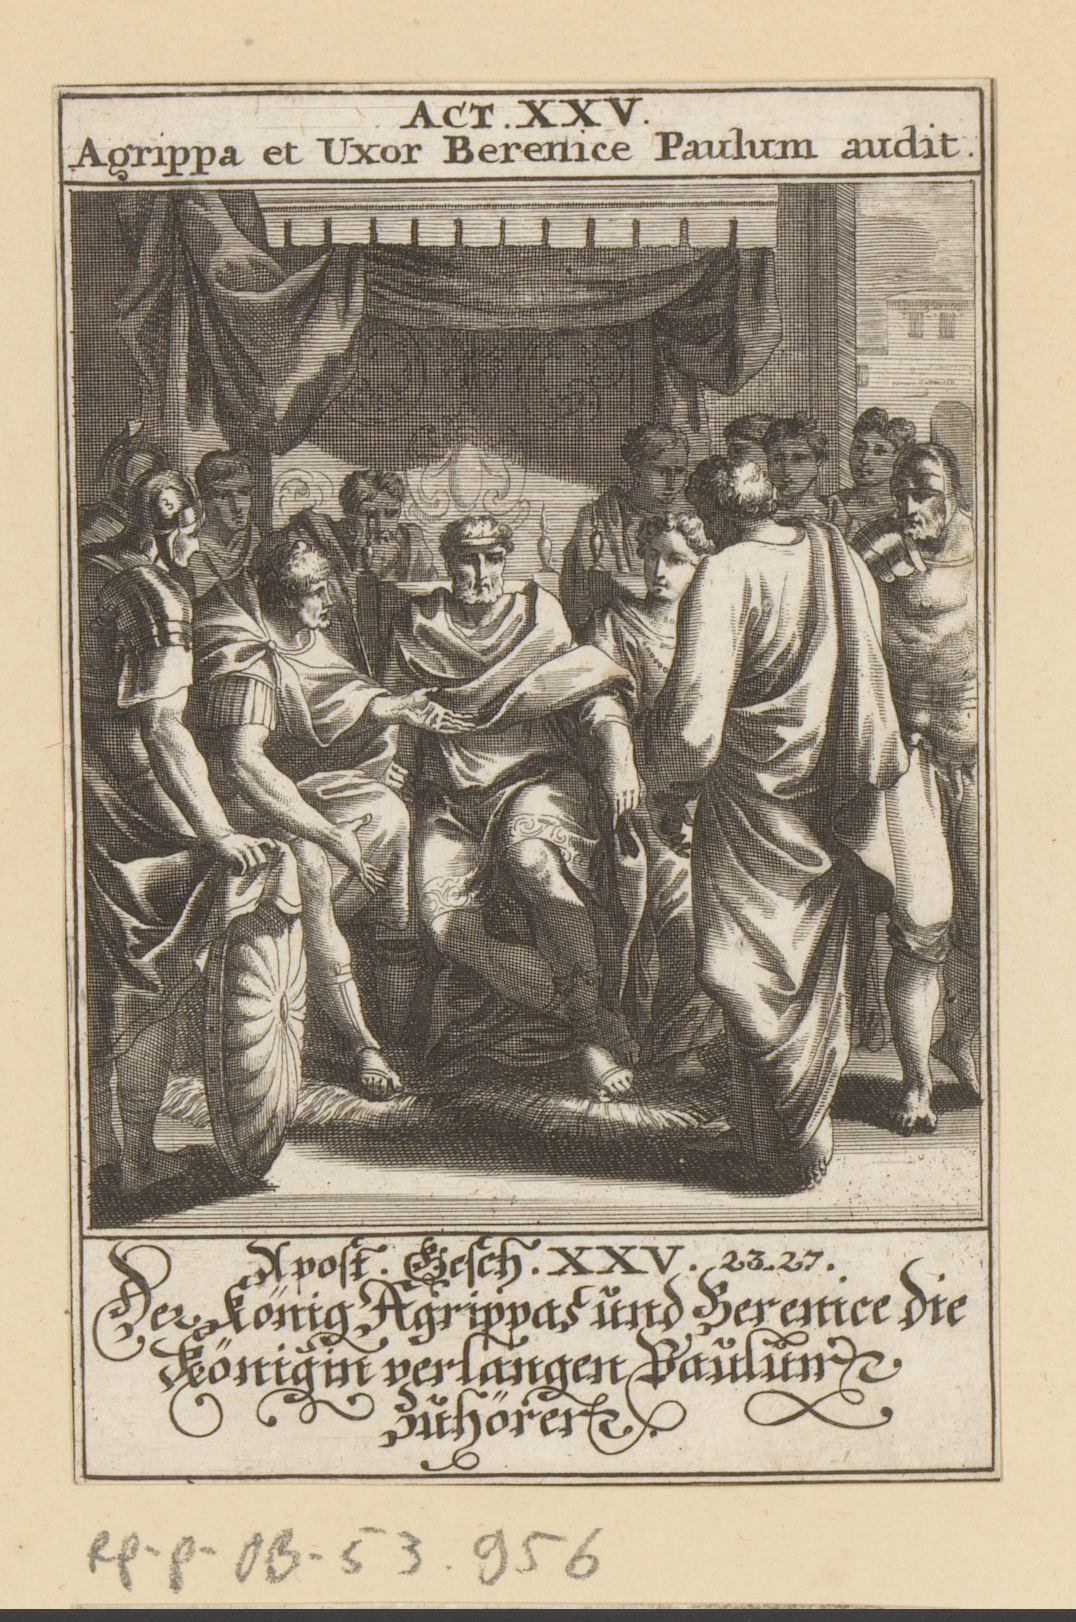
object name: print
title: Koning Herodes Agrippa II en Julia Berenice horen apostel Paulus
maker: Anonymous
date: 1697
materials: paper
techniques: etching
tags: paul before festus, king agrippa and queen bernice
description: Prent ook gebruikt in: Biblia ectypa : Bildnussen auss Heiliger Schrifft. Regensburg: Chr. Wiegel, 1697.